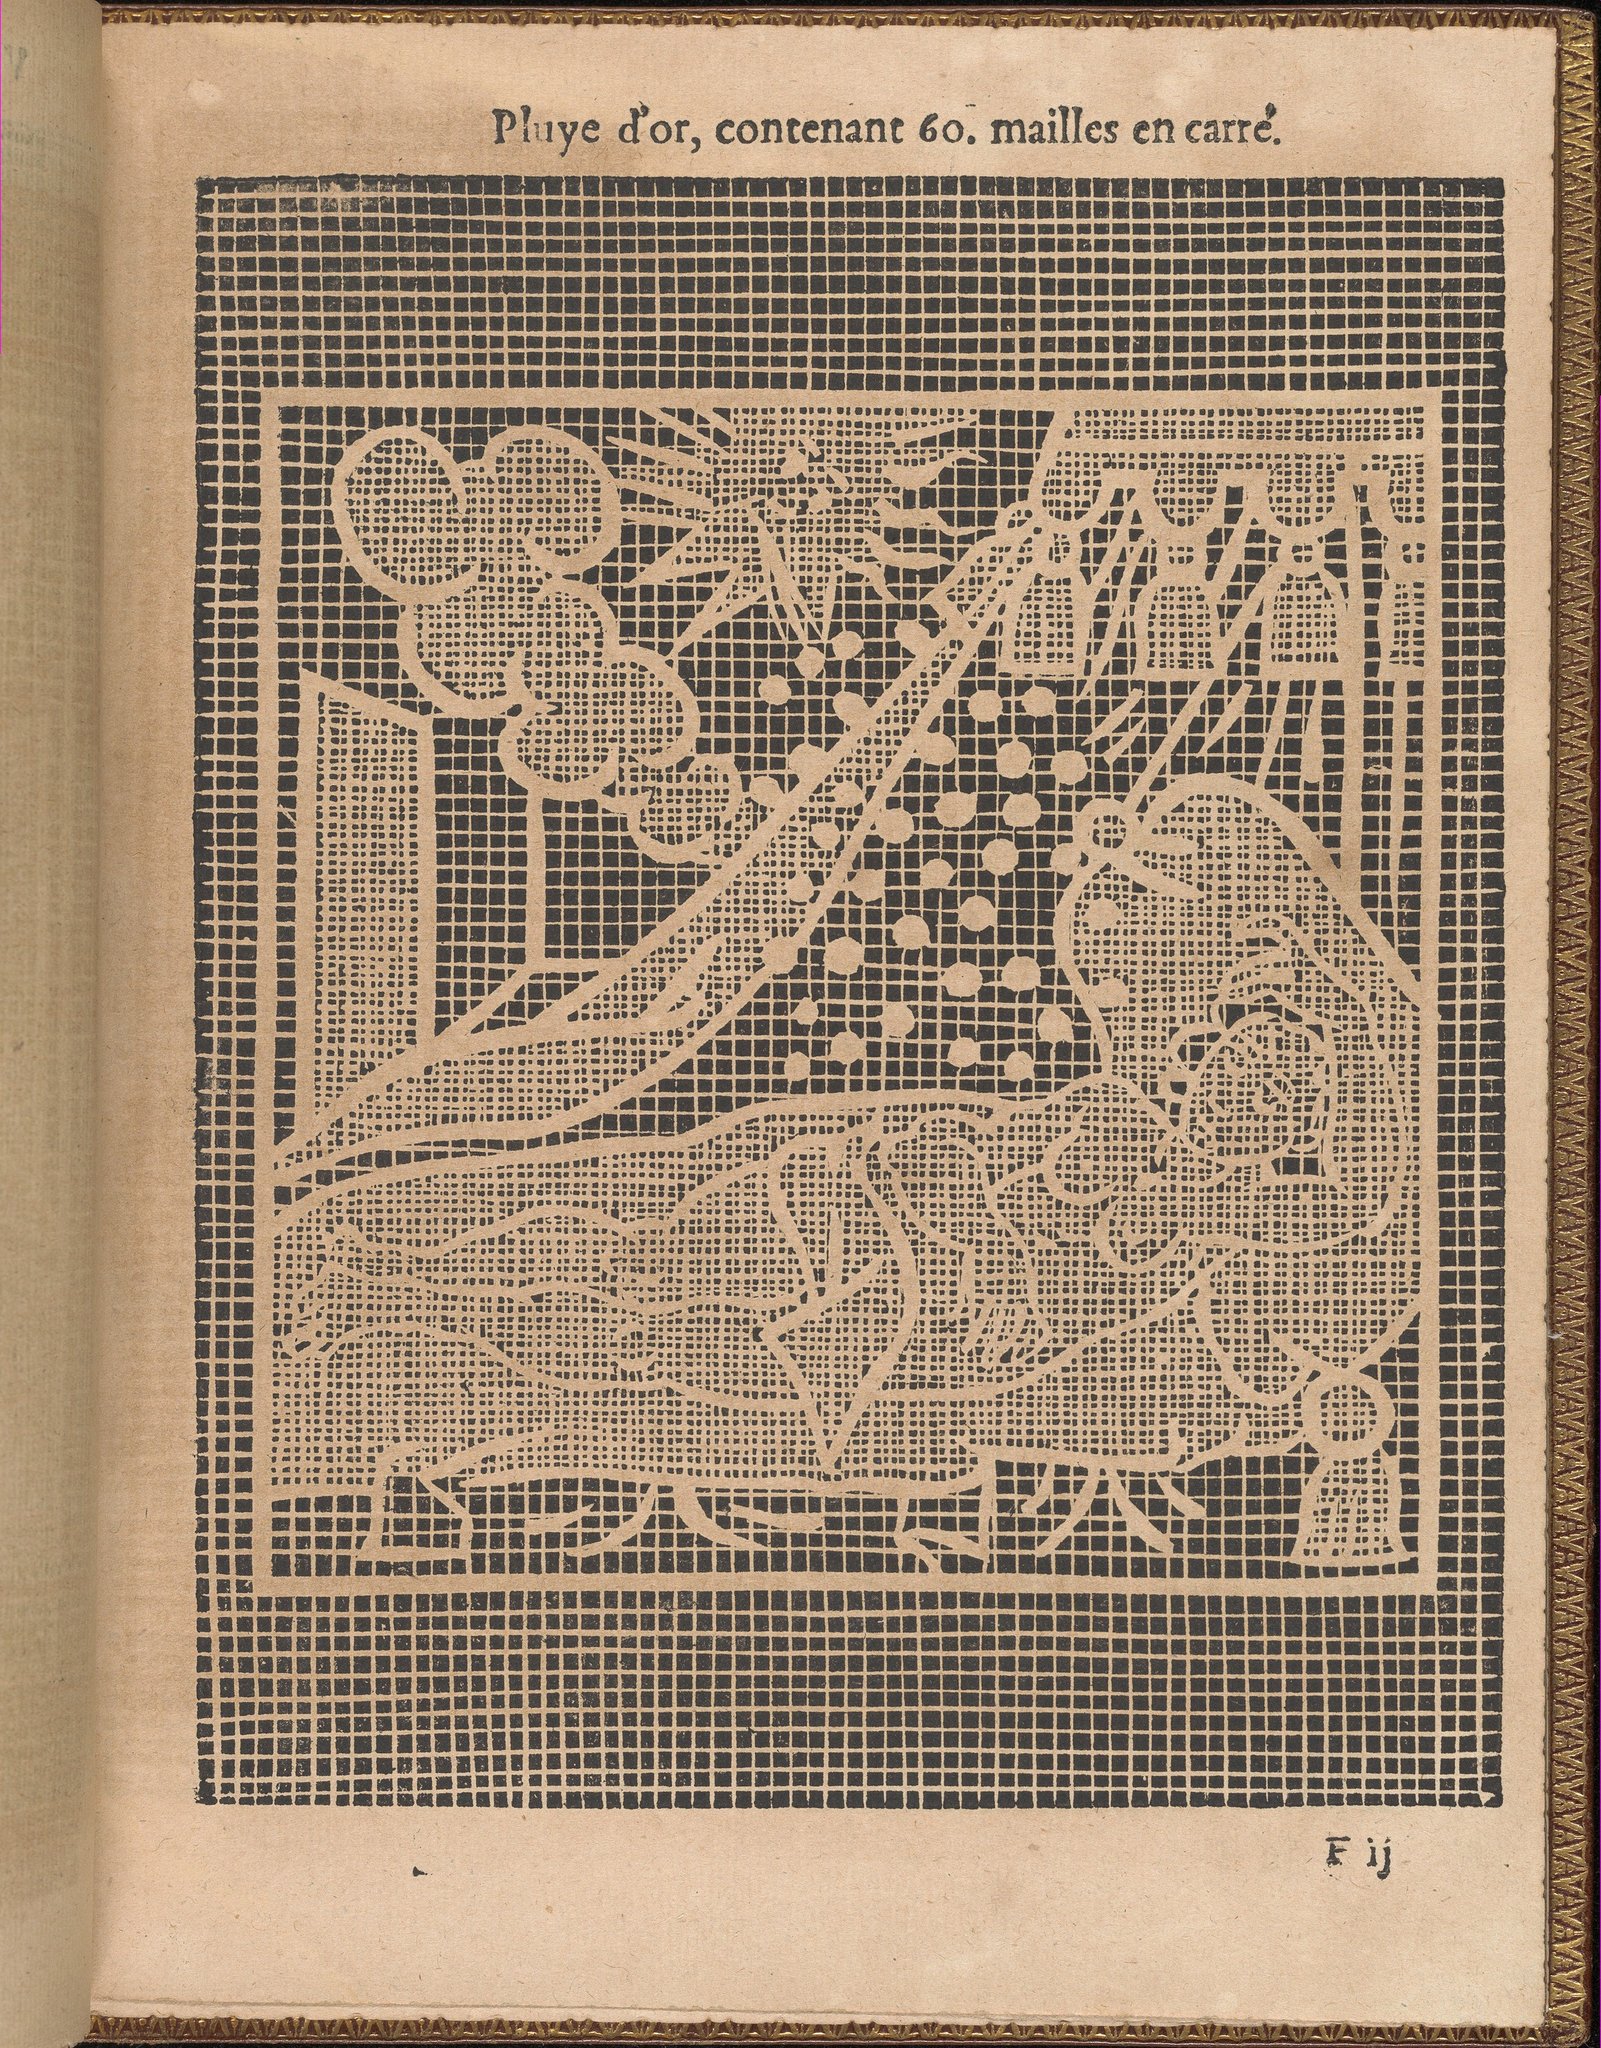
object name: book print ornament architecture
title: La Pratique de l'Aiguille, page 21 (recto)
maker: matthias mignerak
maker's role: author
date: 1605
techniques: woodcut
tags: female nudes,rain